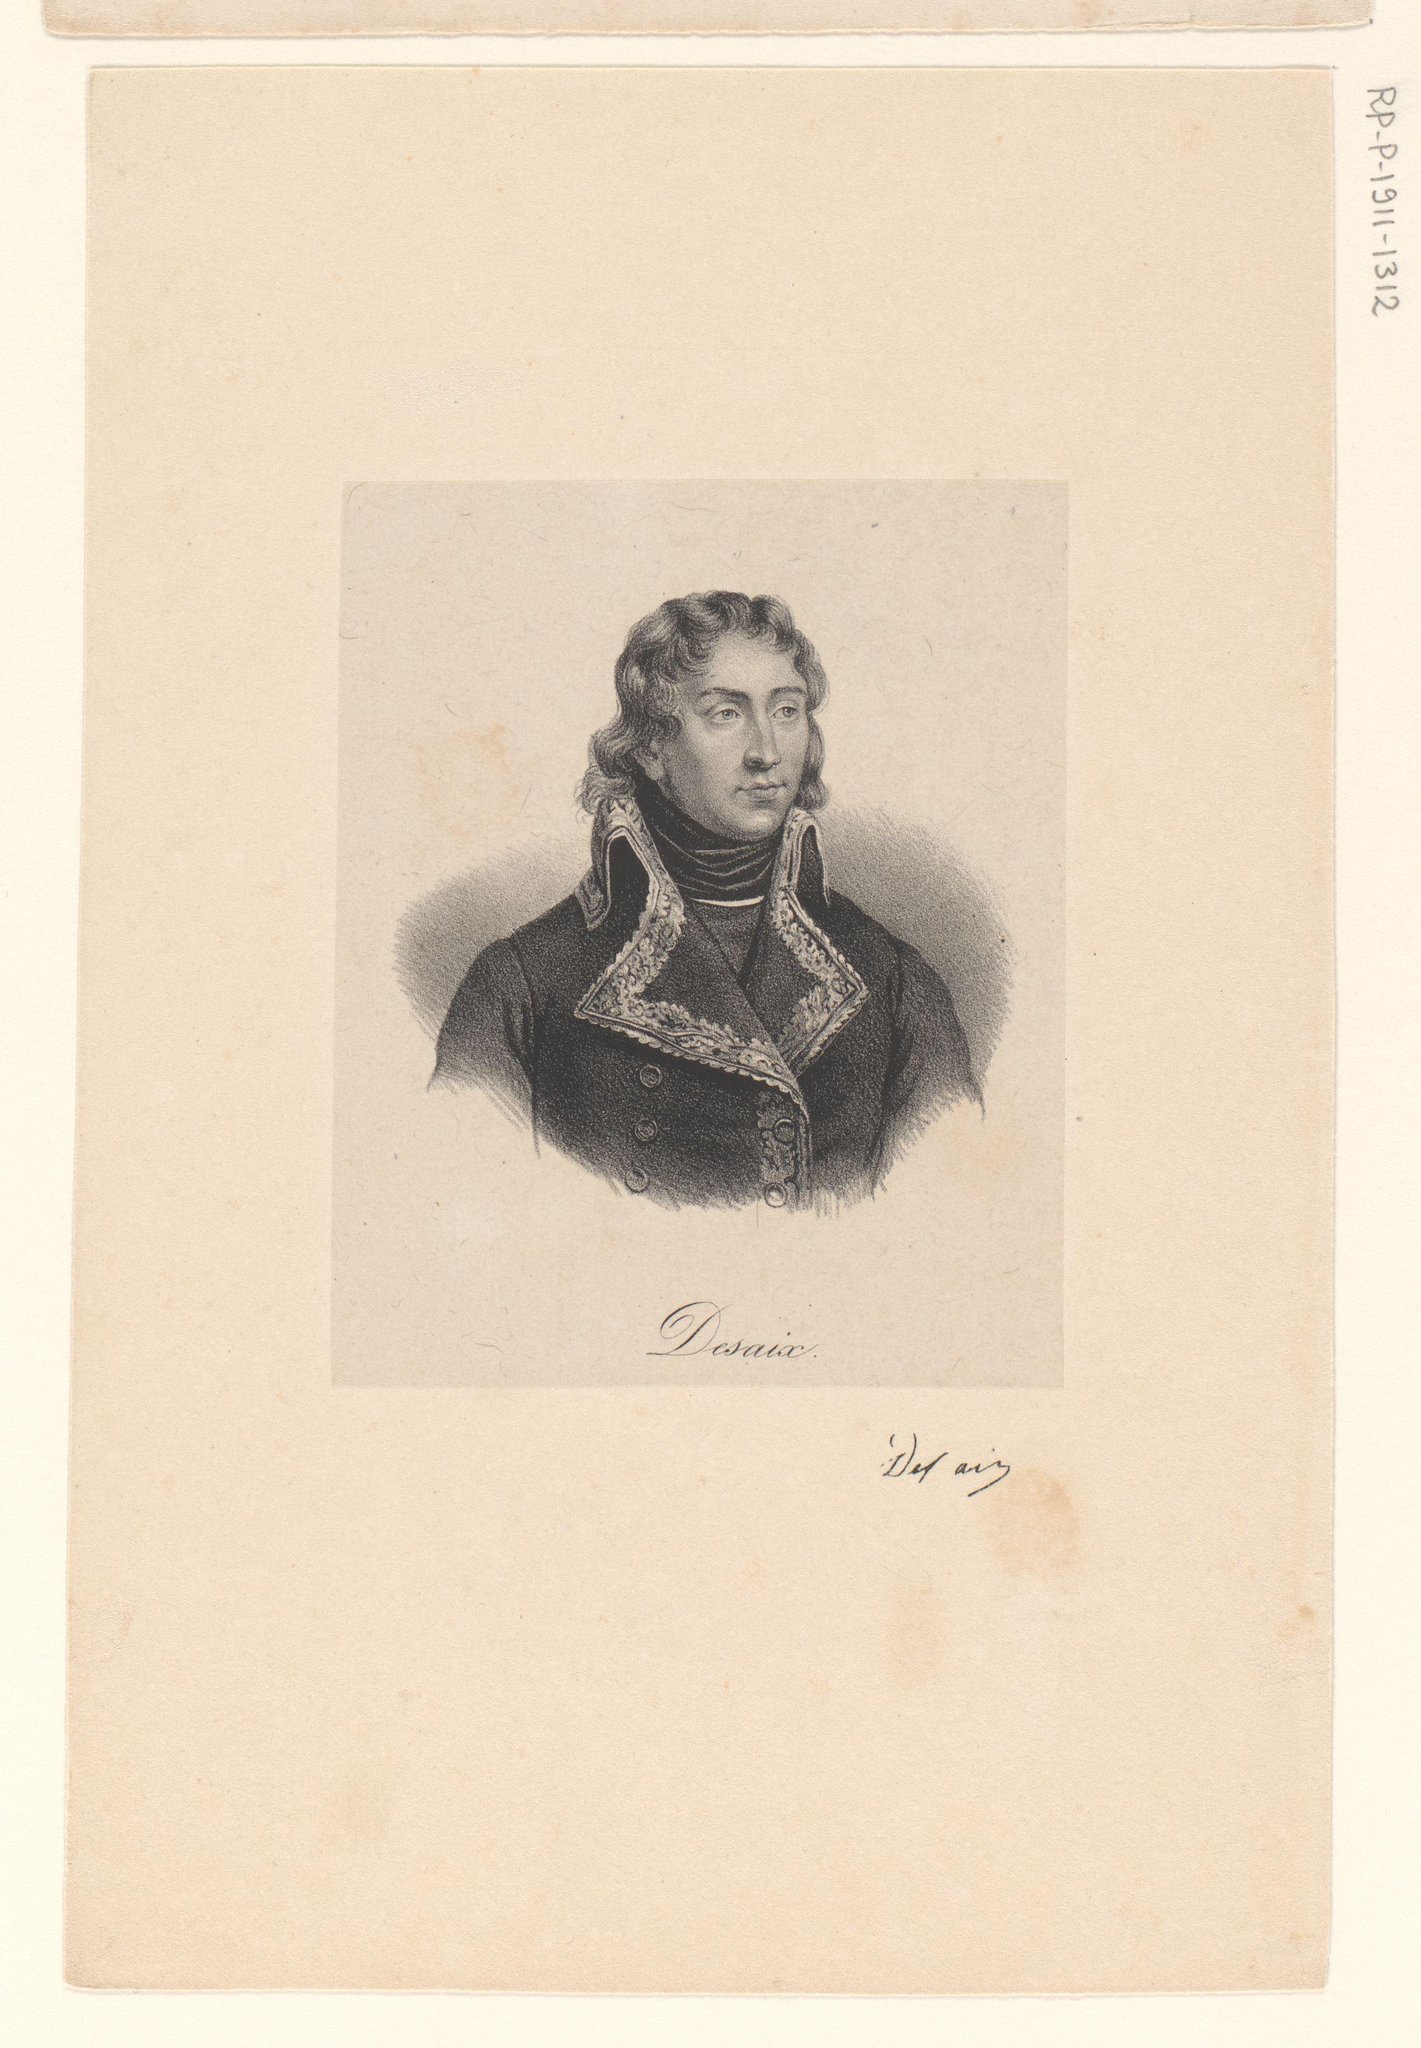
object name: print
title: Desaix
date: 1818-1842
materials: paper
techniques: lithograph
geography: paris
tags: historical persons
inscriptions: collector's mark: Lugt 2228a